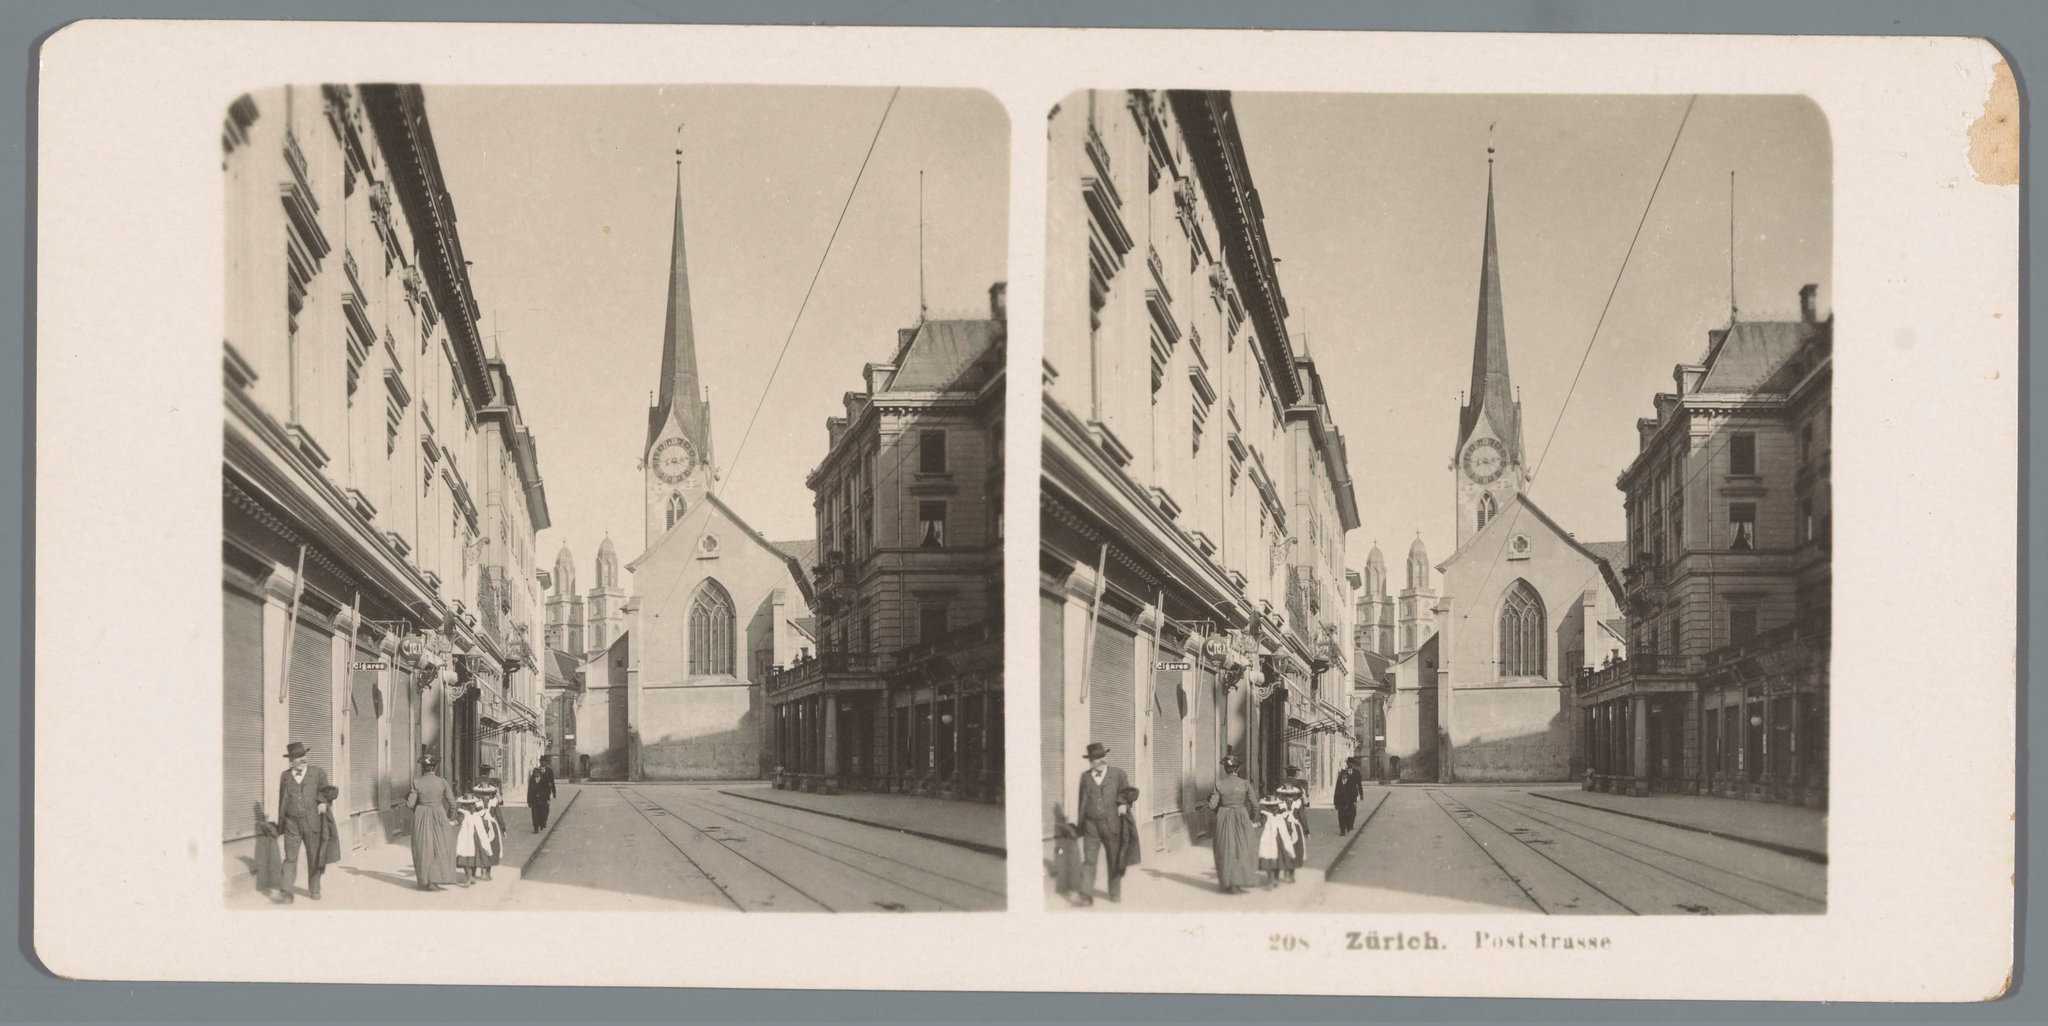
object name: stereograph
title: Gezicht op de Poststrasse te Zürich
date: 1906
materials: cardboard, photographic support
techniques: gelatin silver print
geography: zurich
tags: façade (of house or building), street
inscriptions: inscription: ‘Neue Photographische Gesellschaft A. G., Steglitz-Berlin 1906.’, number: ‘208’